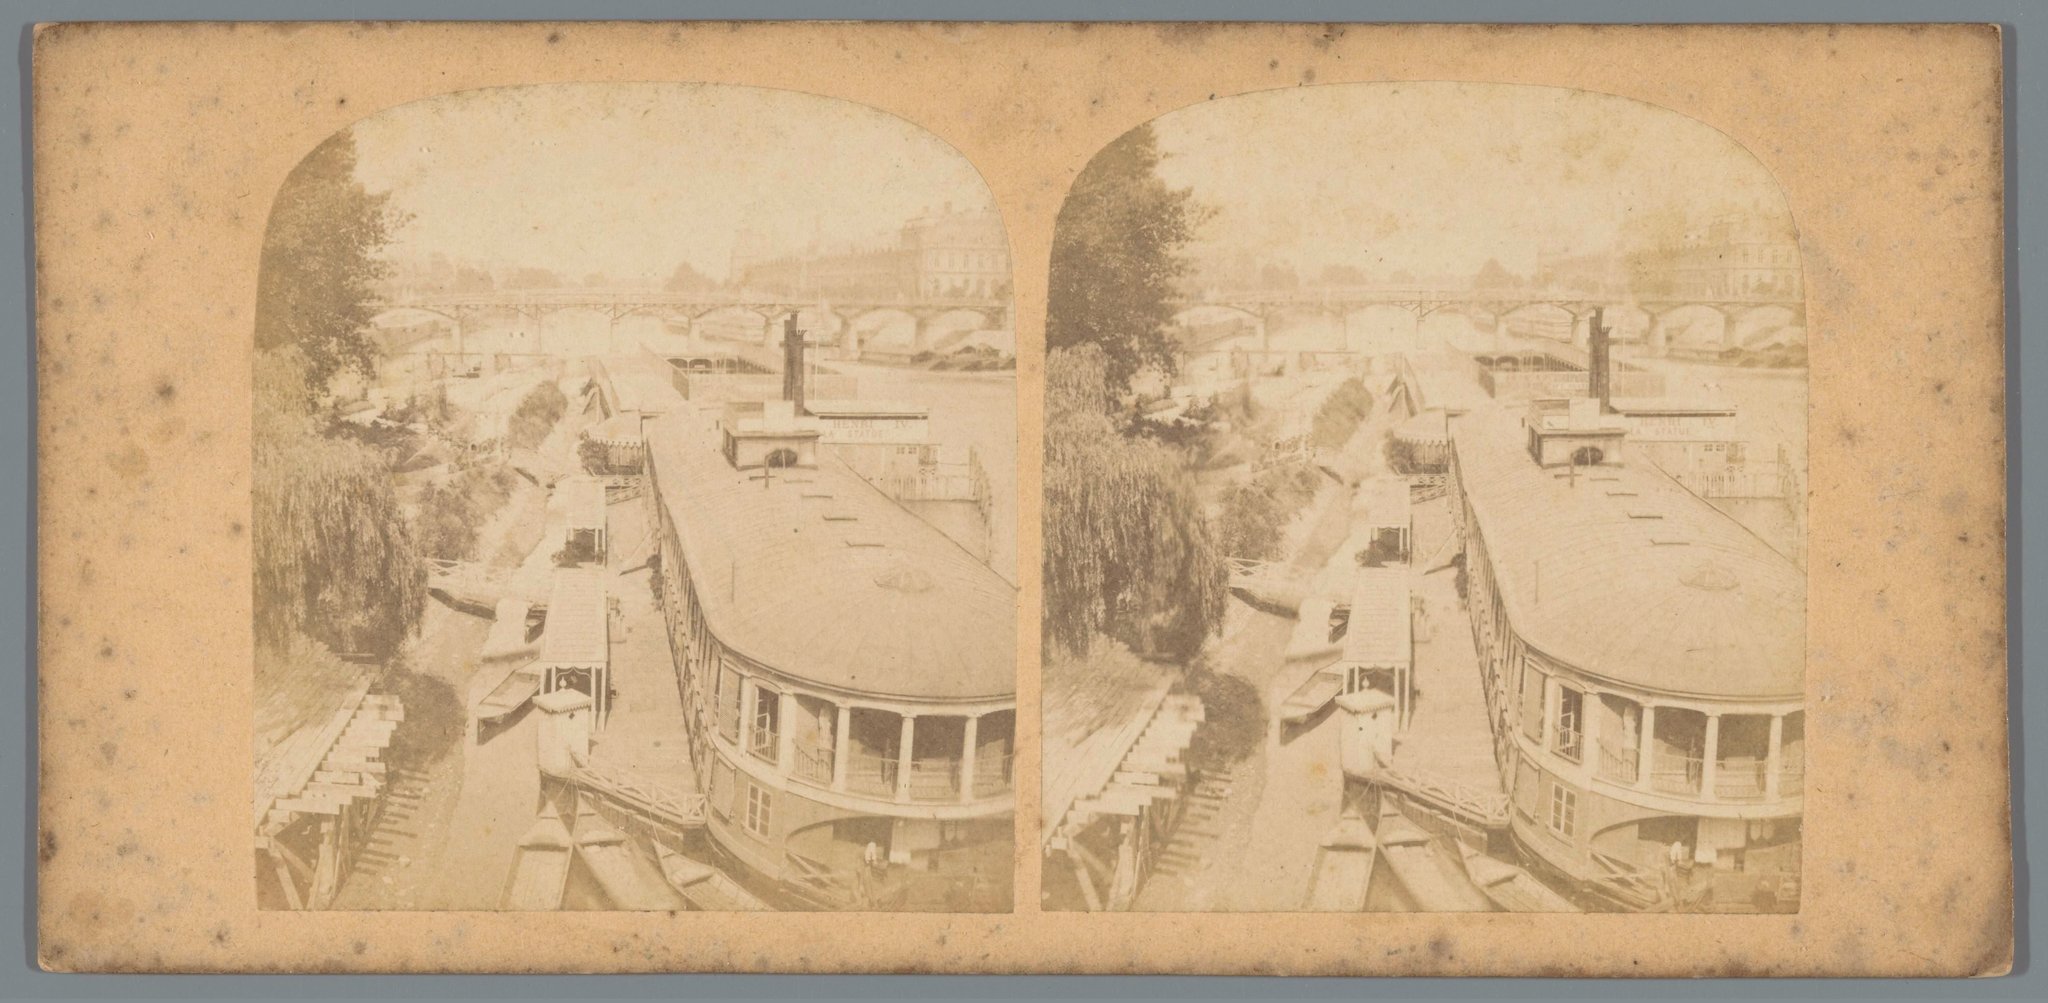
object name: stereograph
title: Gezicht over de Seine met vermoedelijk een badhuis in Parijs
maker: Anonymous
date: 1850-1880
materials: cardboard, photographic support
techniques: albumen print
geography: paris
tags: river, public baths, paris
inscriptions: inscription: ‘Panorama sur la Seine’